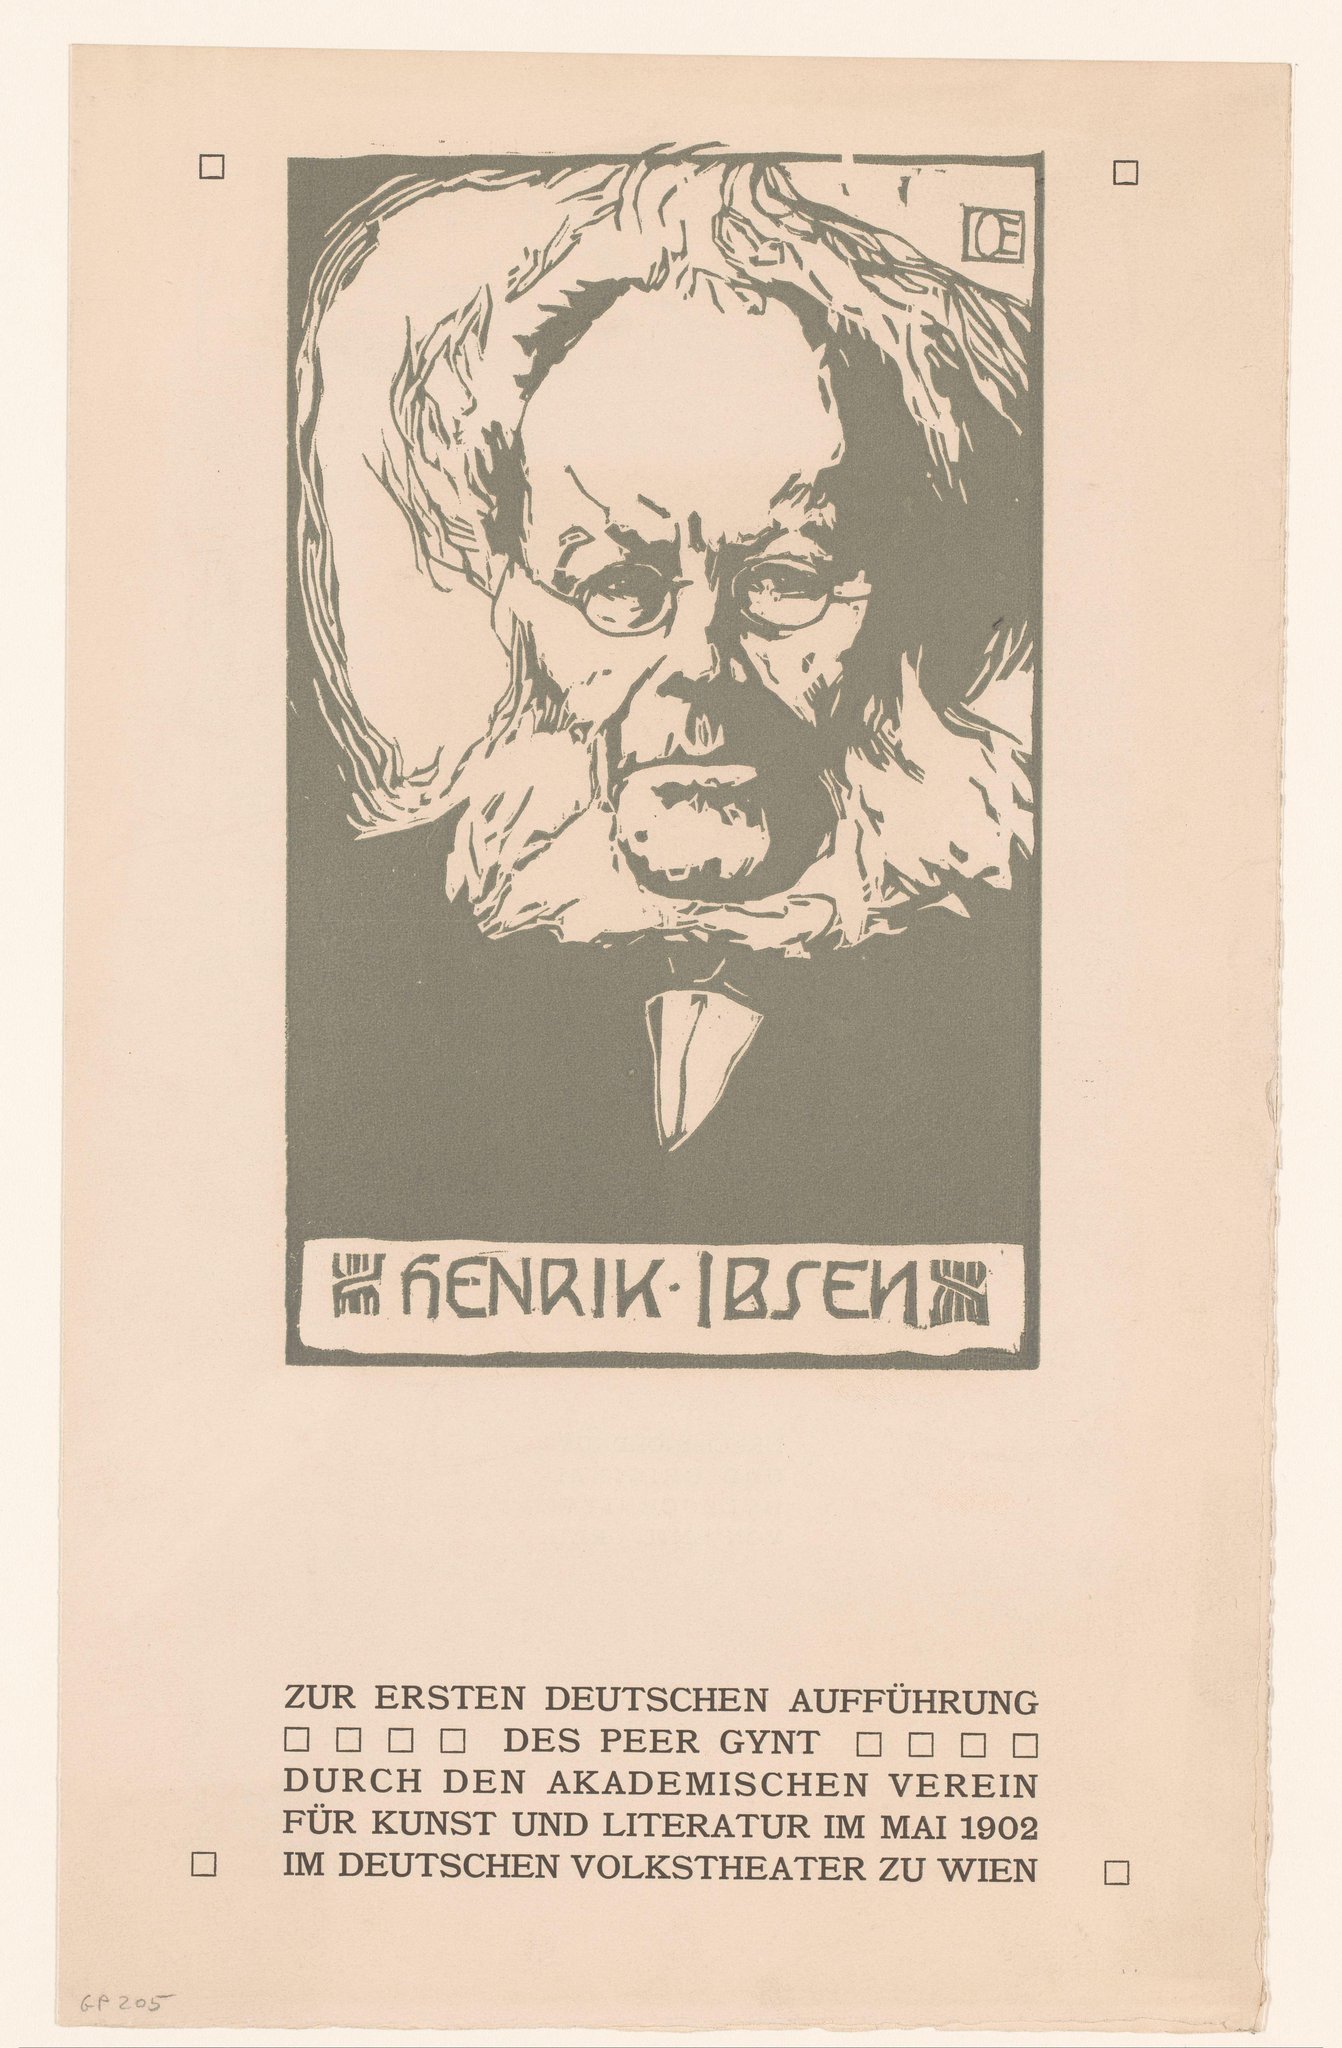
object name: print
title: Portret van Hendrik Ibsen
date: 1902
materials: paper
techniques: printing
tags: theatre, theatrical performance, historical persons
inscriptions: collector's mark: Lugt 2760, collector's mark: Lugt 2228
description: Programma voor een voorstelling van het stuk "Peer Gynt" in 1902 te Wenen met een portret van de toneelschrijver Hendrik Ibsen, een berglandschap en een treurende vrouw bij het lichaam van een man.